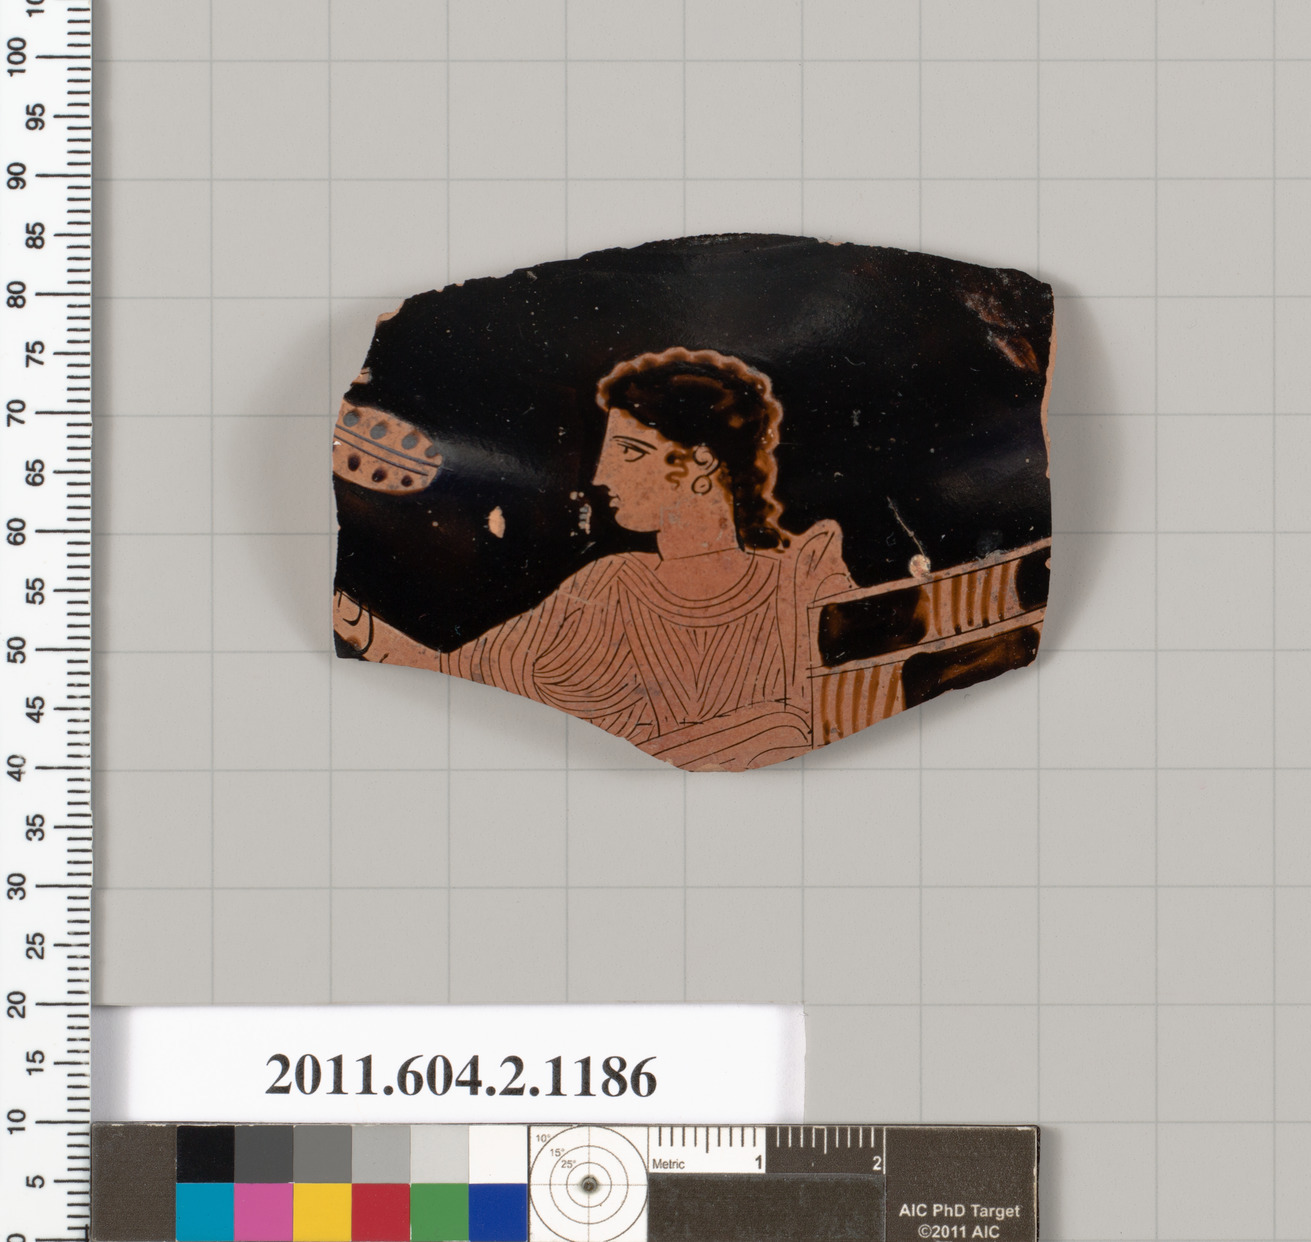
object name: lebes gamikos fragment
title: Terracotta fragment of a lebes gamikos (round-bottomed bowl with handles and stands used for weddings)?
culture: greek, attic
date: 430-420 BCE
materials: terracotta